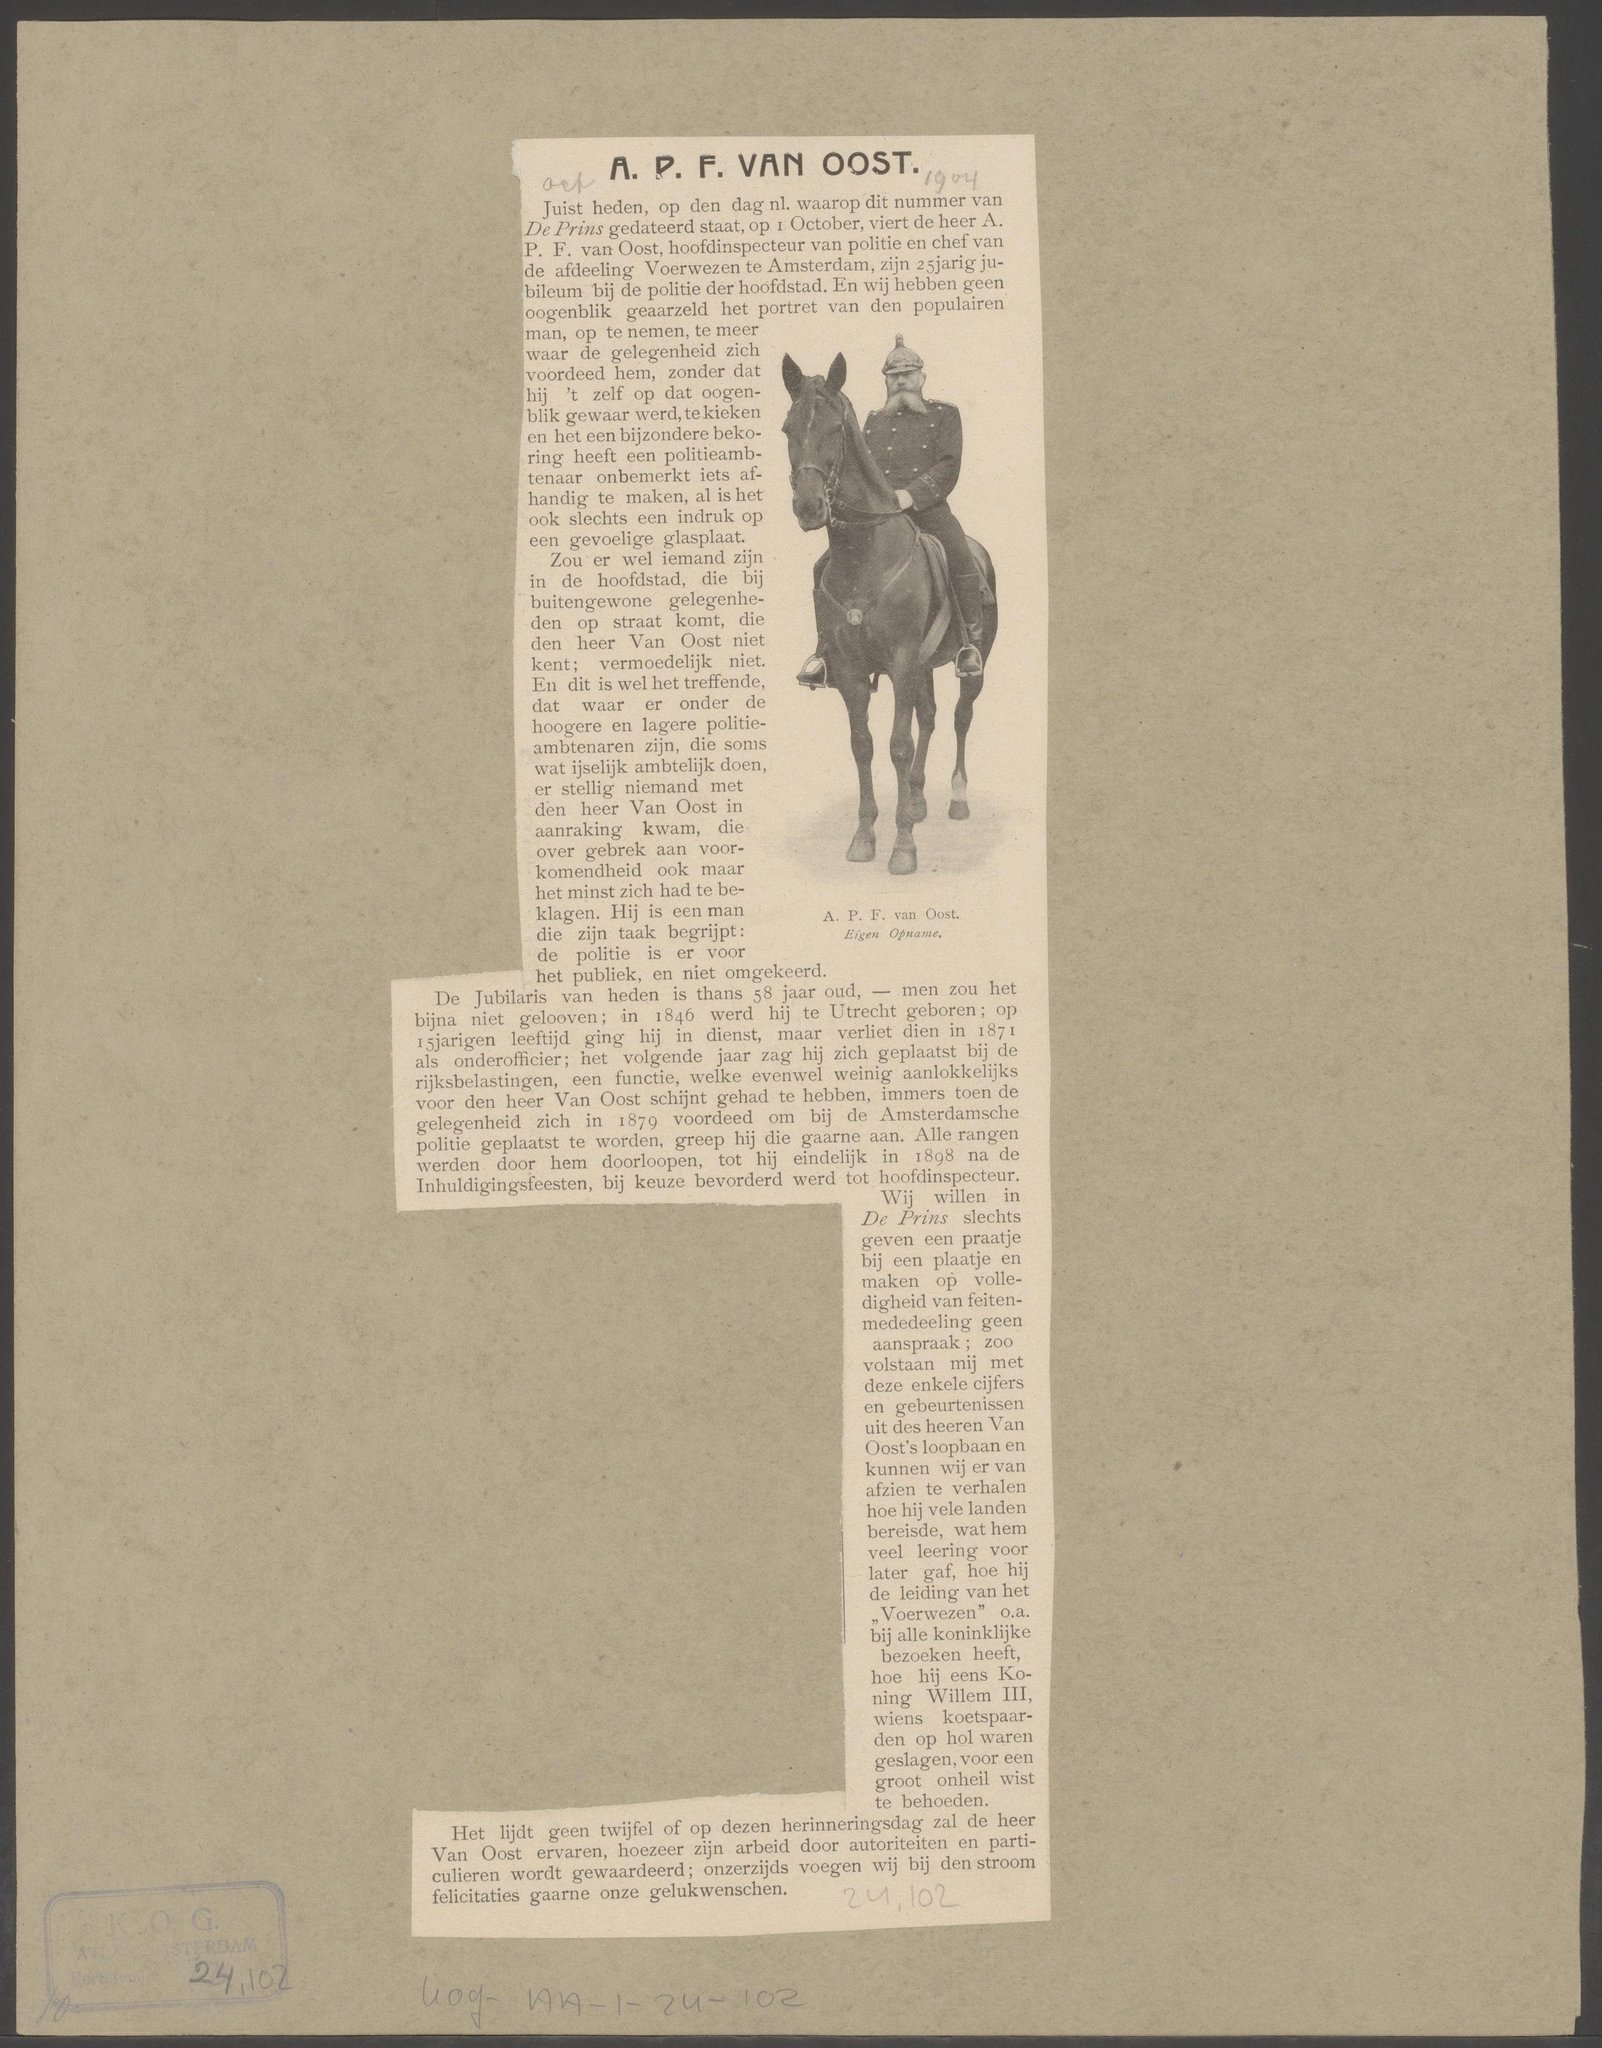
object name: photomechanical print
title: A.P.F. van Oost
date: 1904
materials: paper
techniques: letterpress printing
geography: amsterdam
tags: utrecht, historical persons, horse, amsterdam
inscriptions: collector's mark: Lugt 1641b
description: Onderwerpsrubriek binnen de Atlas Amsterdam: Politie.